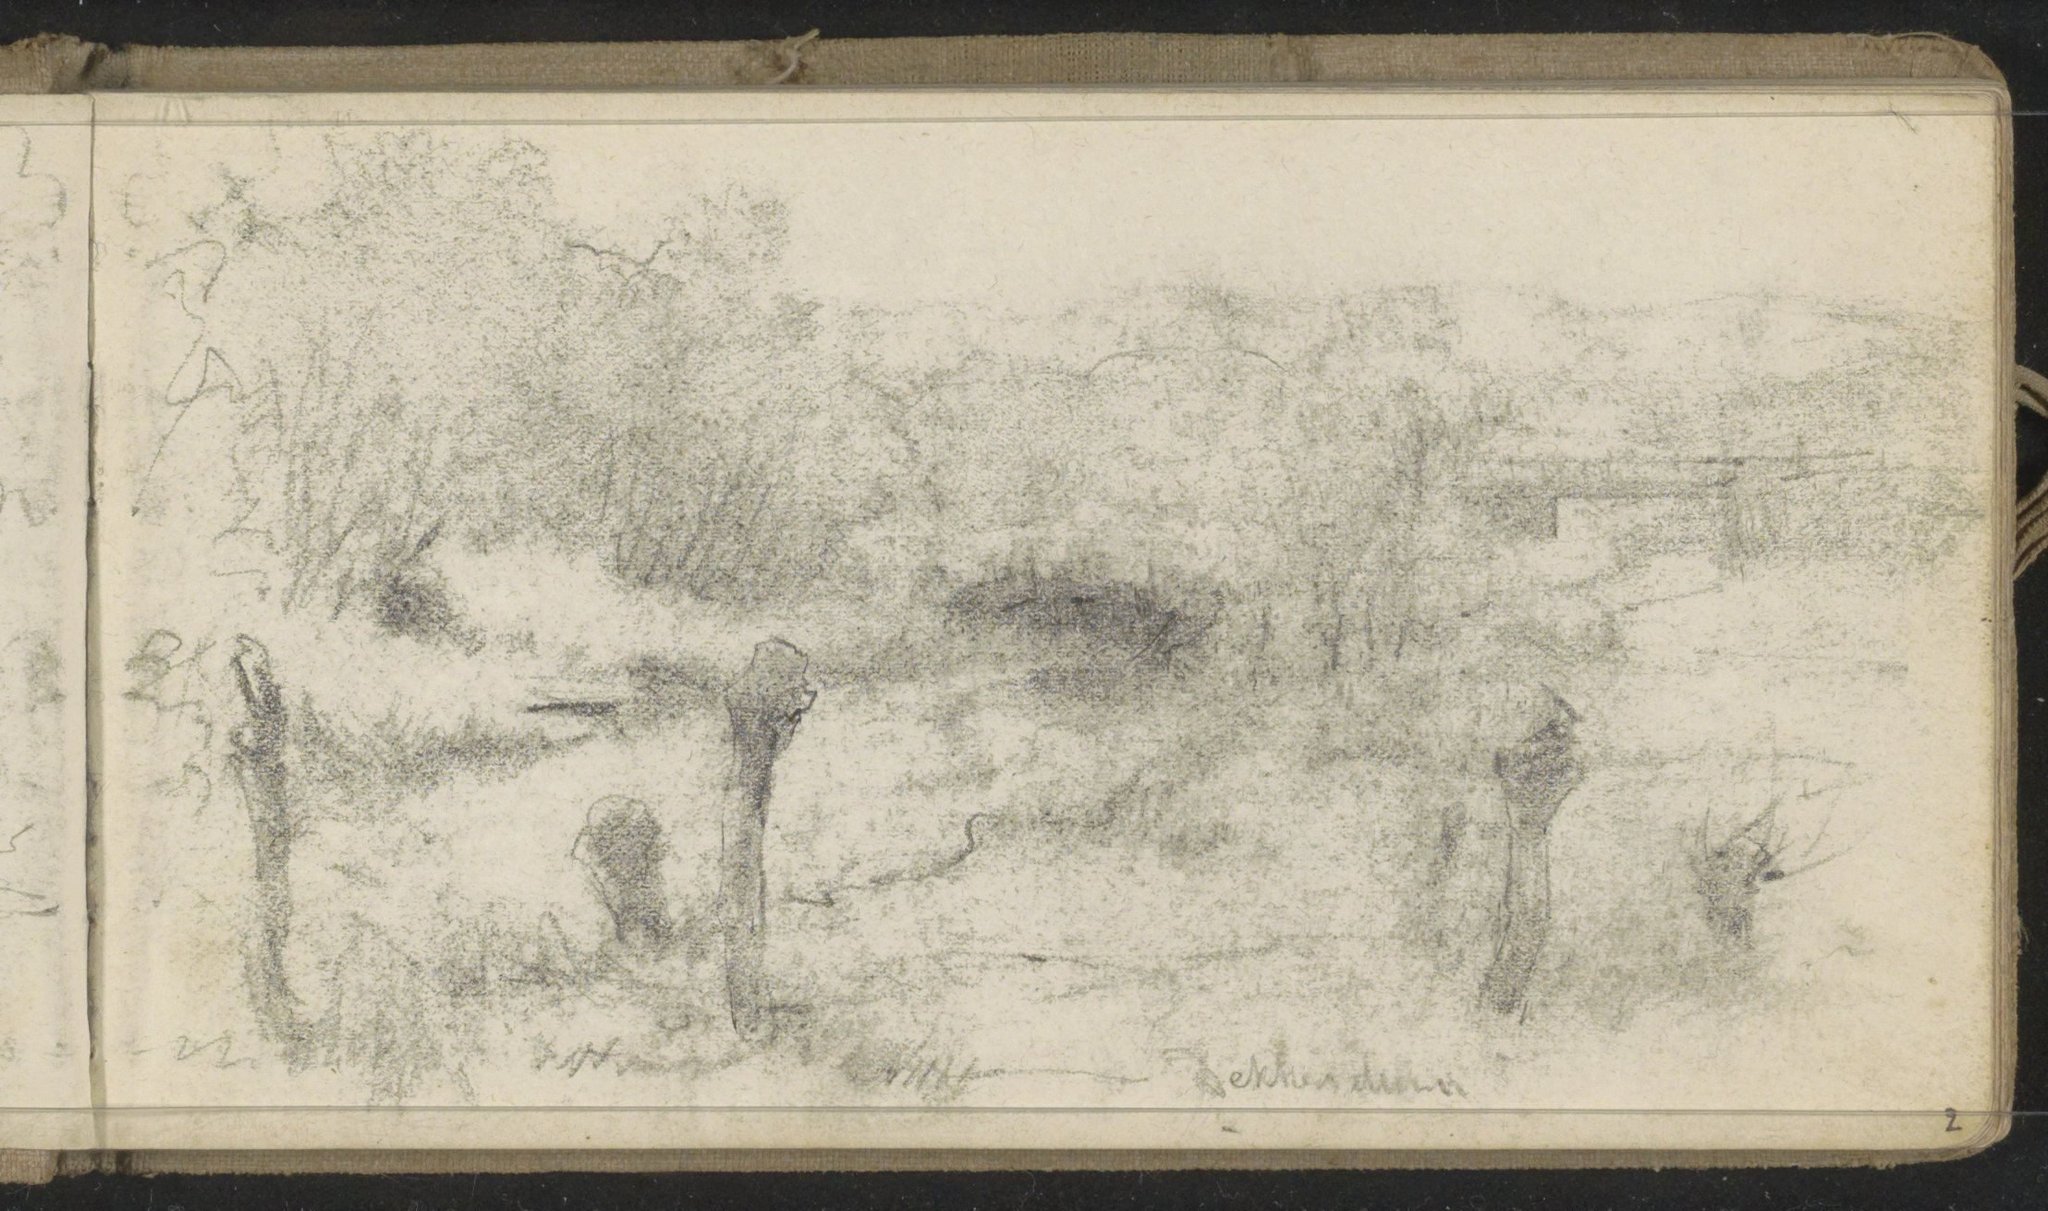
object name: sketchbook leaf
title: Duinlandschap bij Dekkersduin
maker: willem cornelis rip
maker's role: draughtsman, painter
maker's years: 1856-1922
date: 1895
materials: paper, pencil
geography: dekkersduin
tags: dunes (sea not visible); in the dunes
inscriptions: annotation: ‘Dekkersduin’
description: Blad 2 recto uit een schetsboek met 39 bladen.